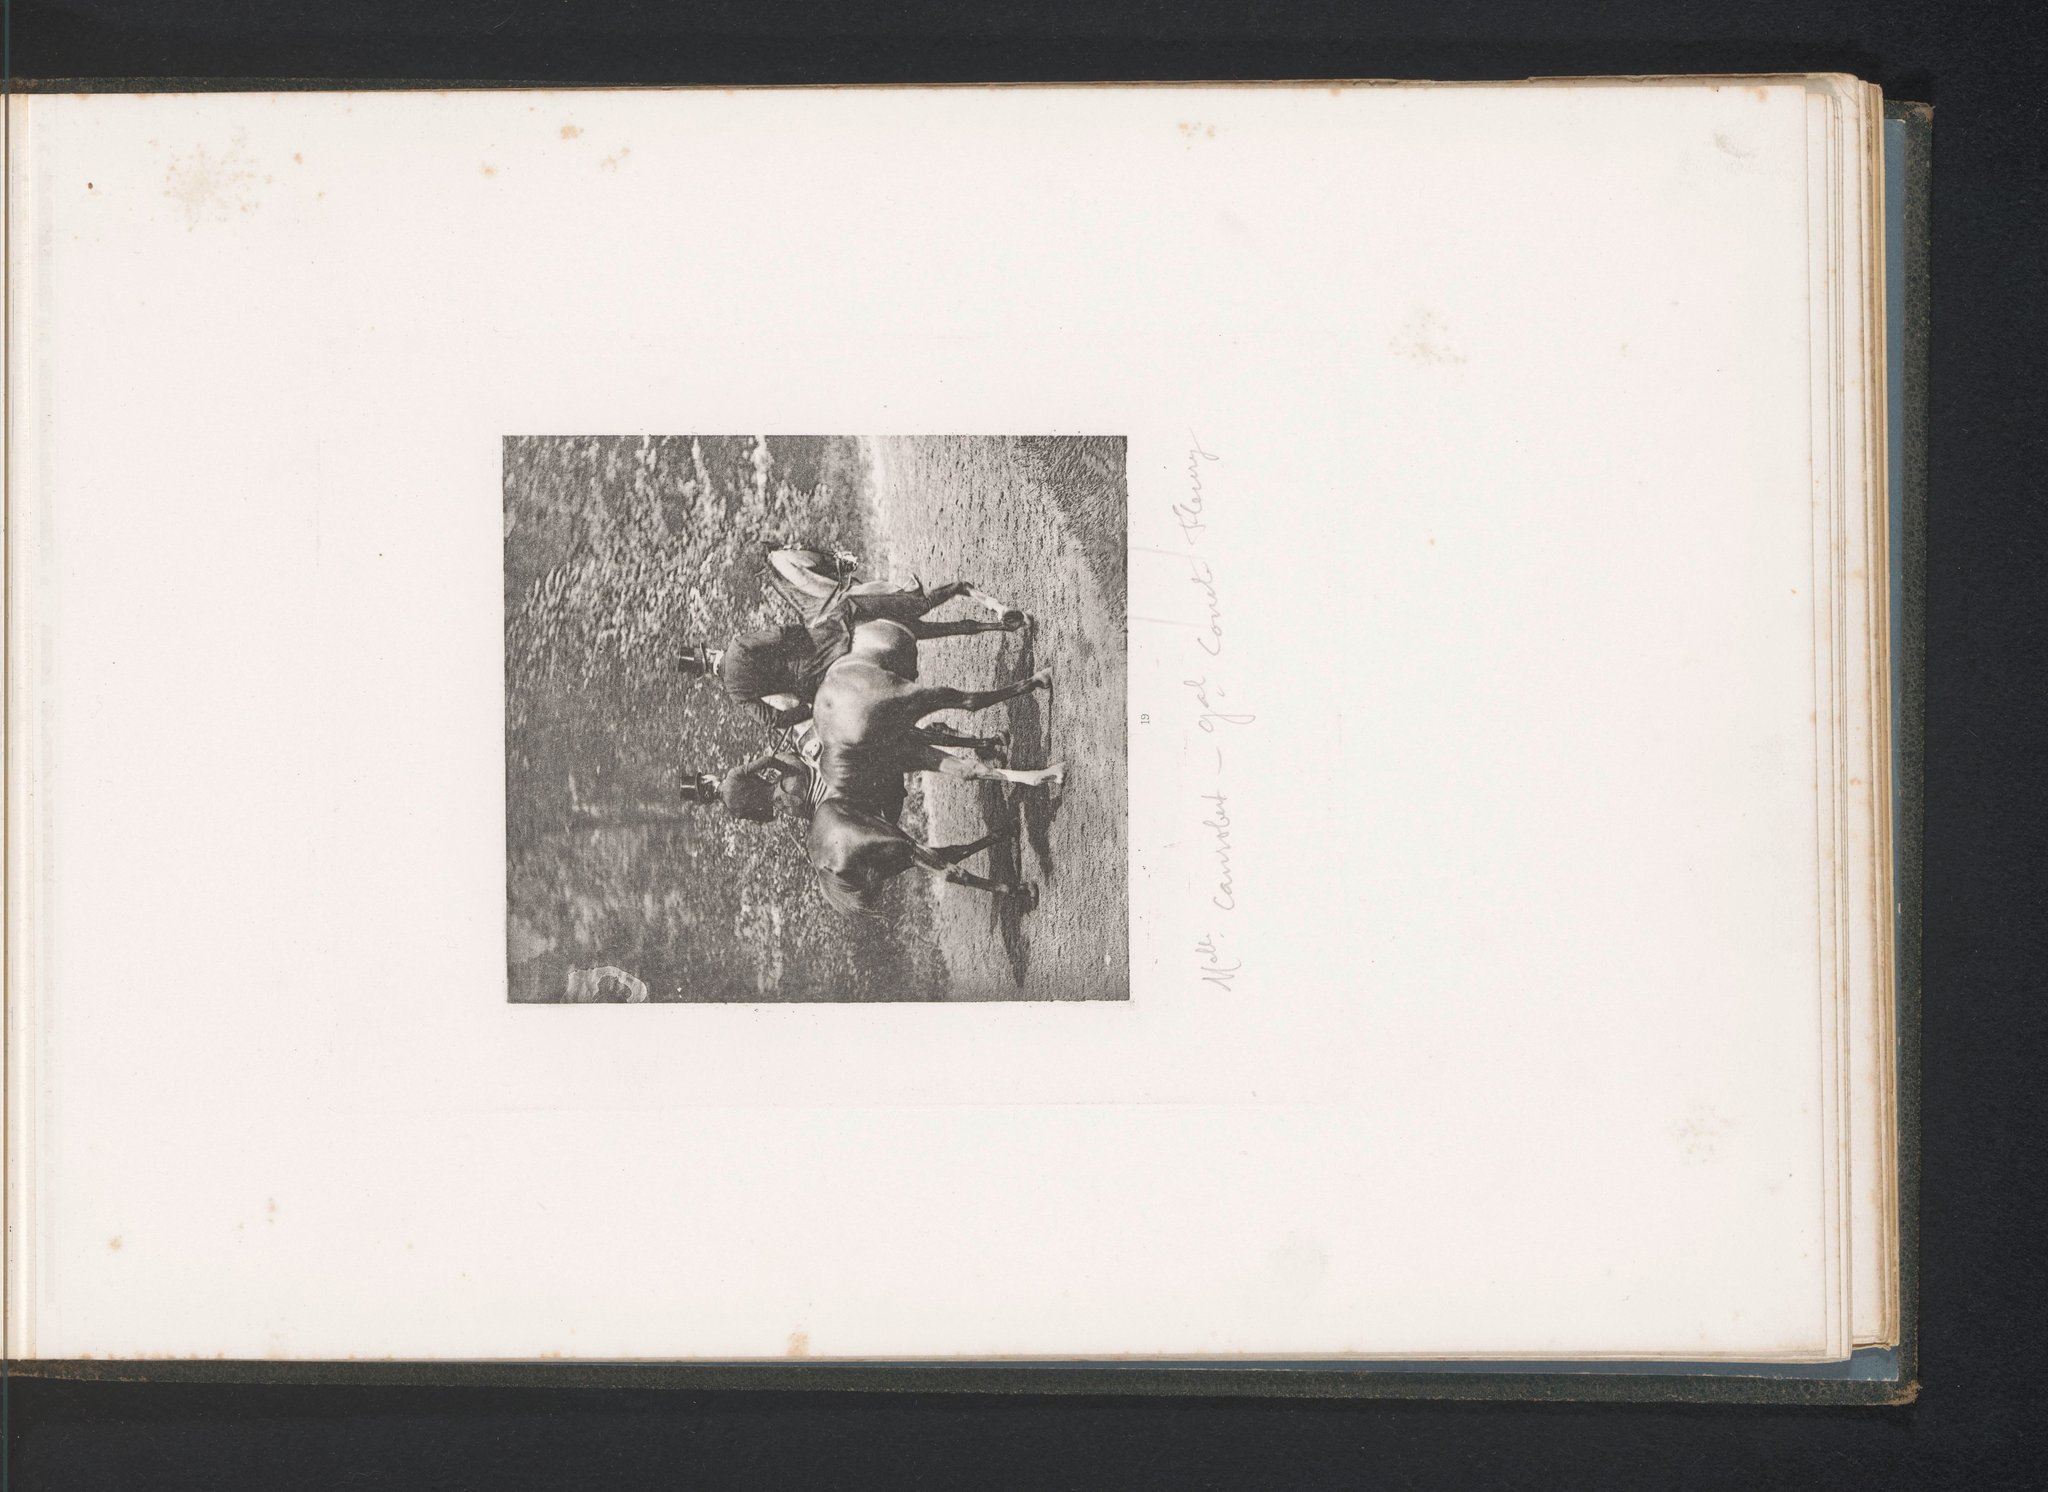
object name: page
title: Twee ruiters te paard op de rug gezien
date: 1874-1884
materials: paper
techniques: photoaquatint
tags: riding a horse, ass, or mule; rider, horseman, head-gear: top hat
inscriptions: number: ‘19’, inscription: ‘Mlle. Canrobert - gal. Comte Fleury’